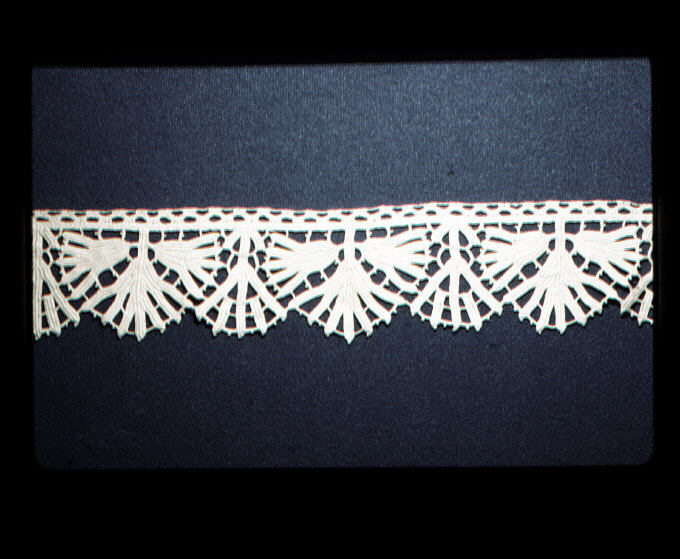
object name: strip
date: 1601-1700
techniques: lace